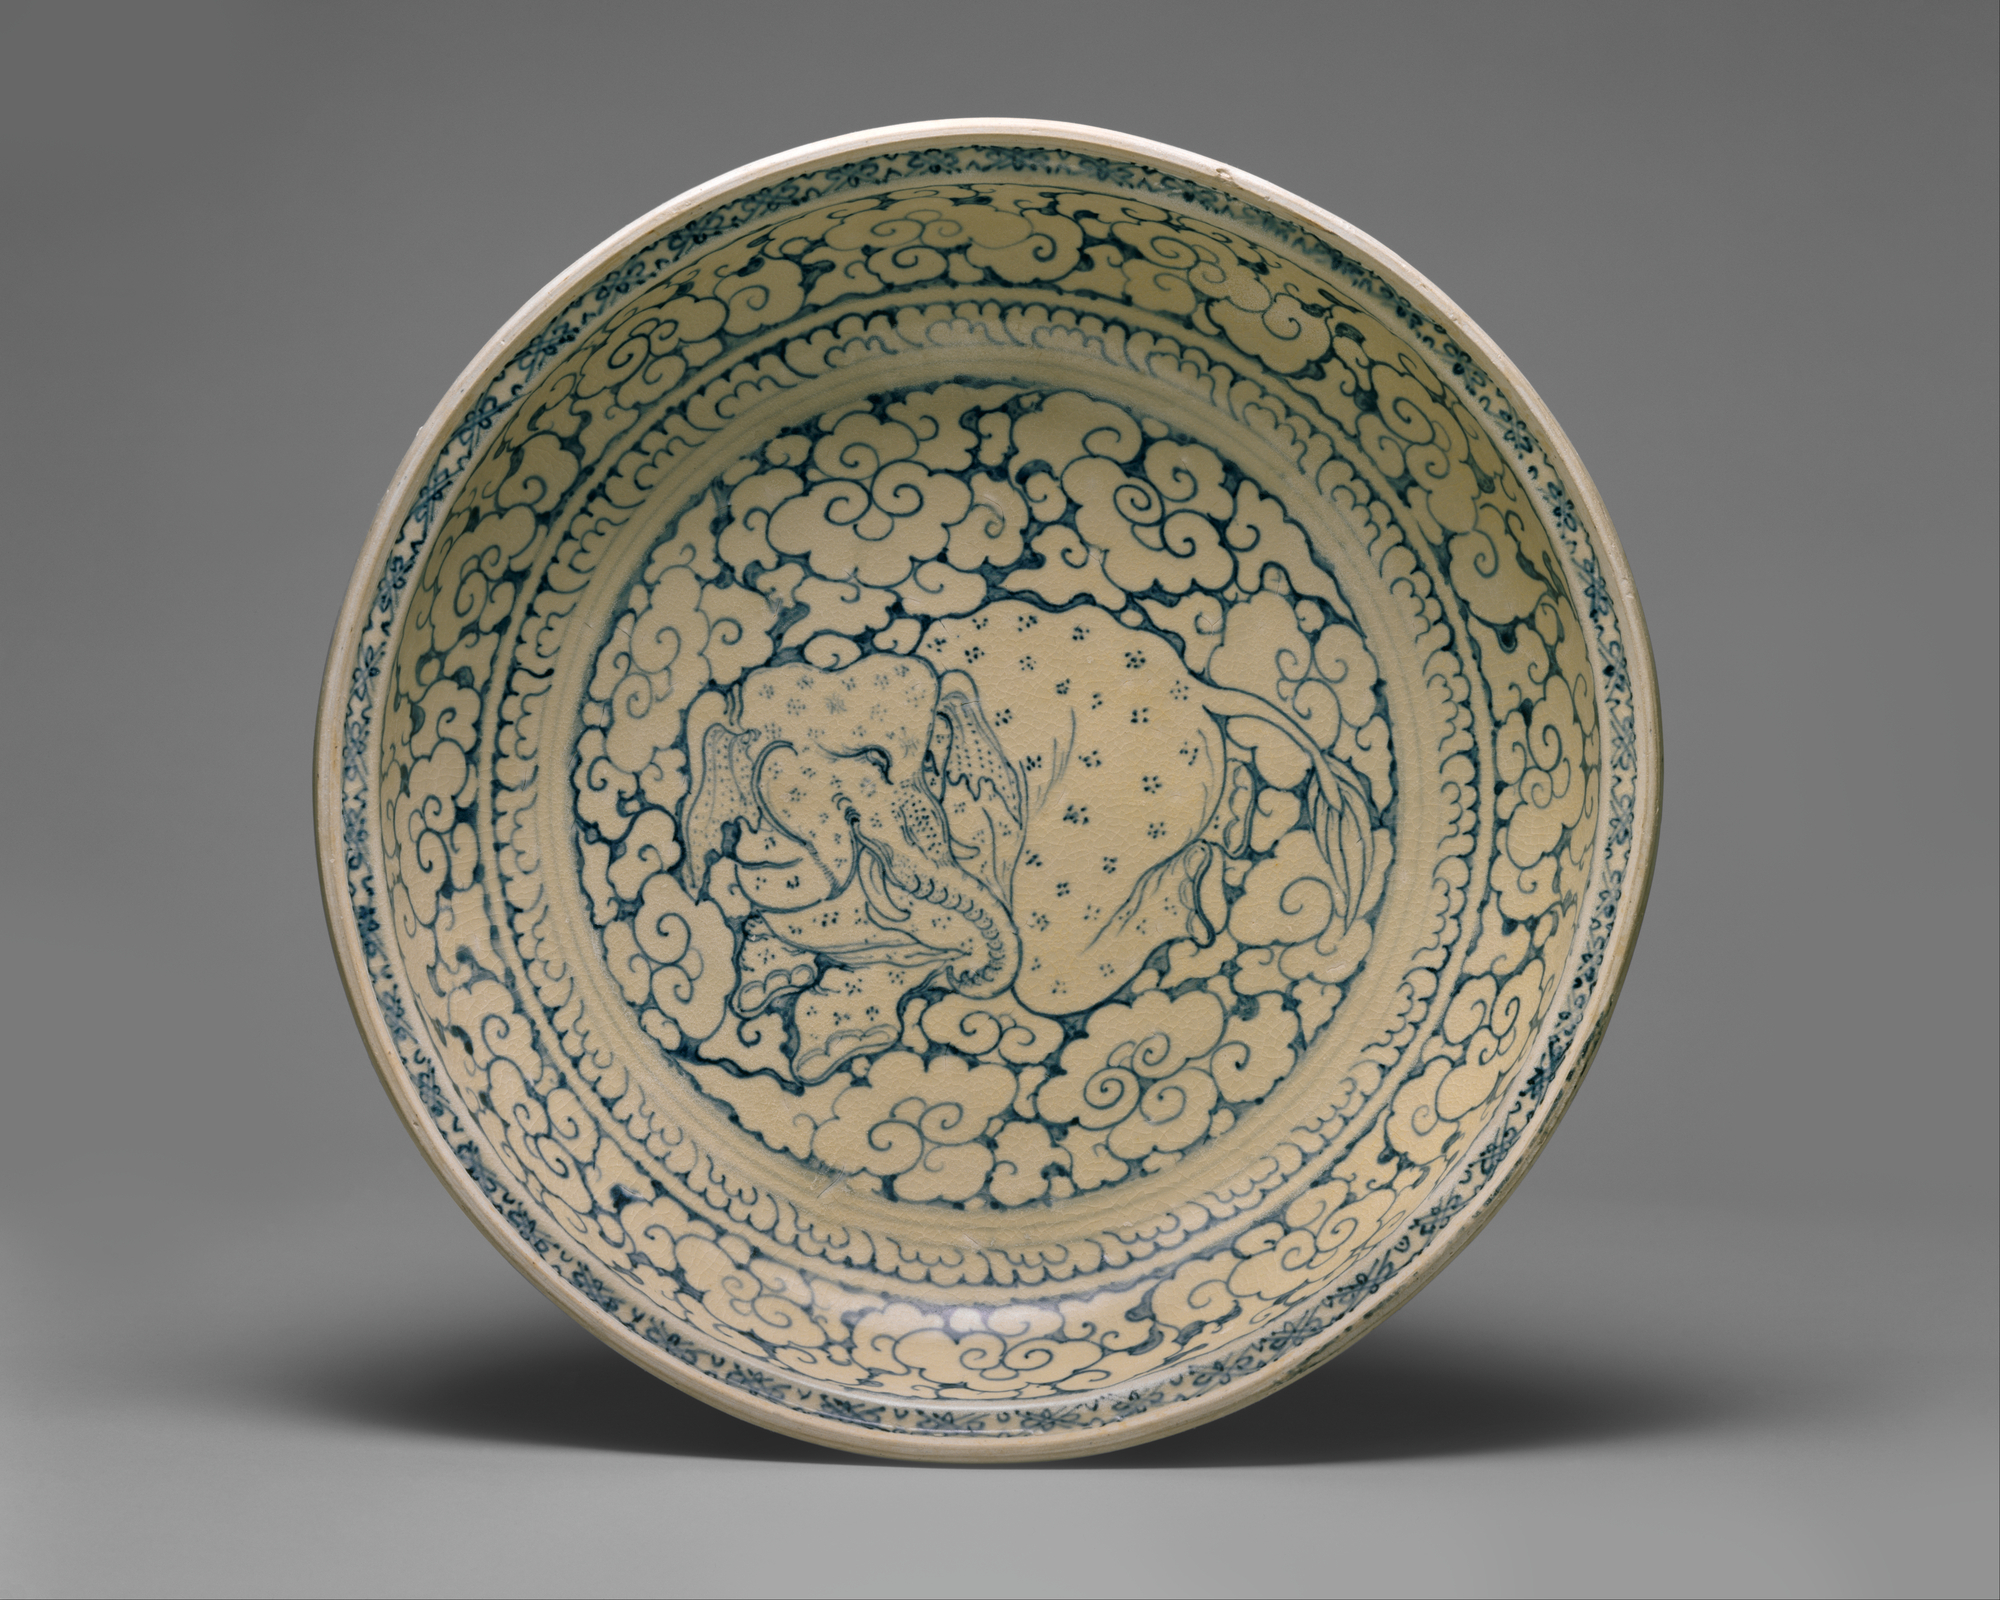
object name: dish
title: Dish with Recumbent Elephant Surrounded by Clouds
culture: vietnamese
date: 1401-1600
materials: cobalt, stoneware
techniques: underglaze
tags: elephants